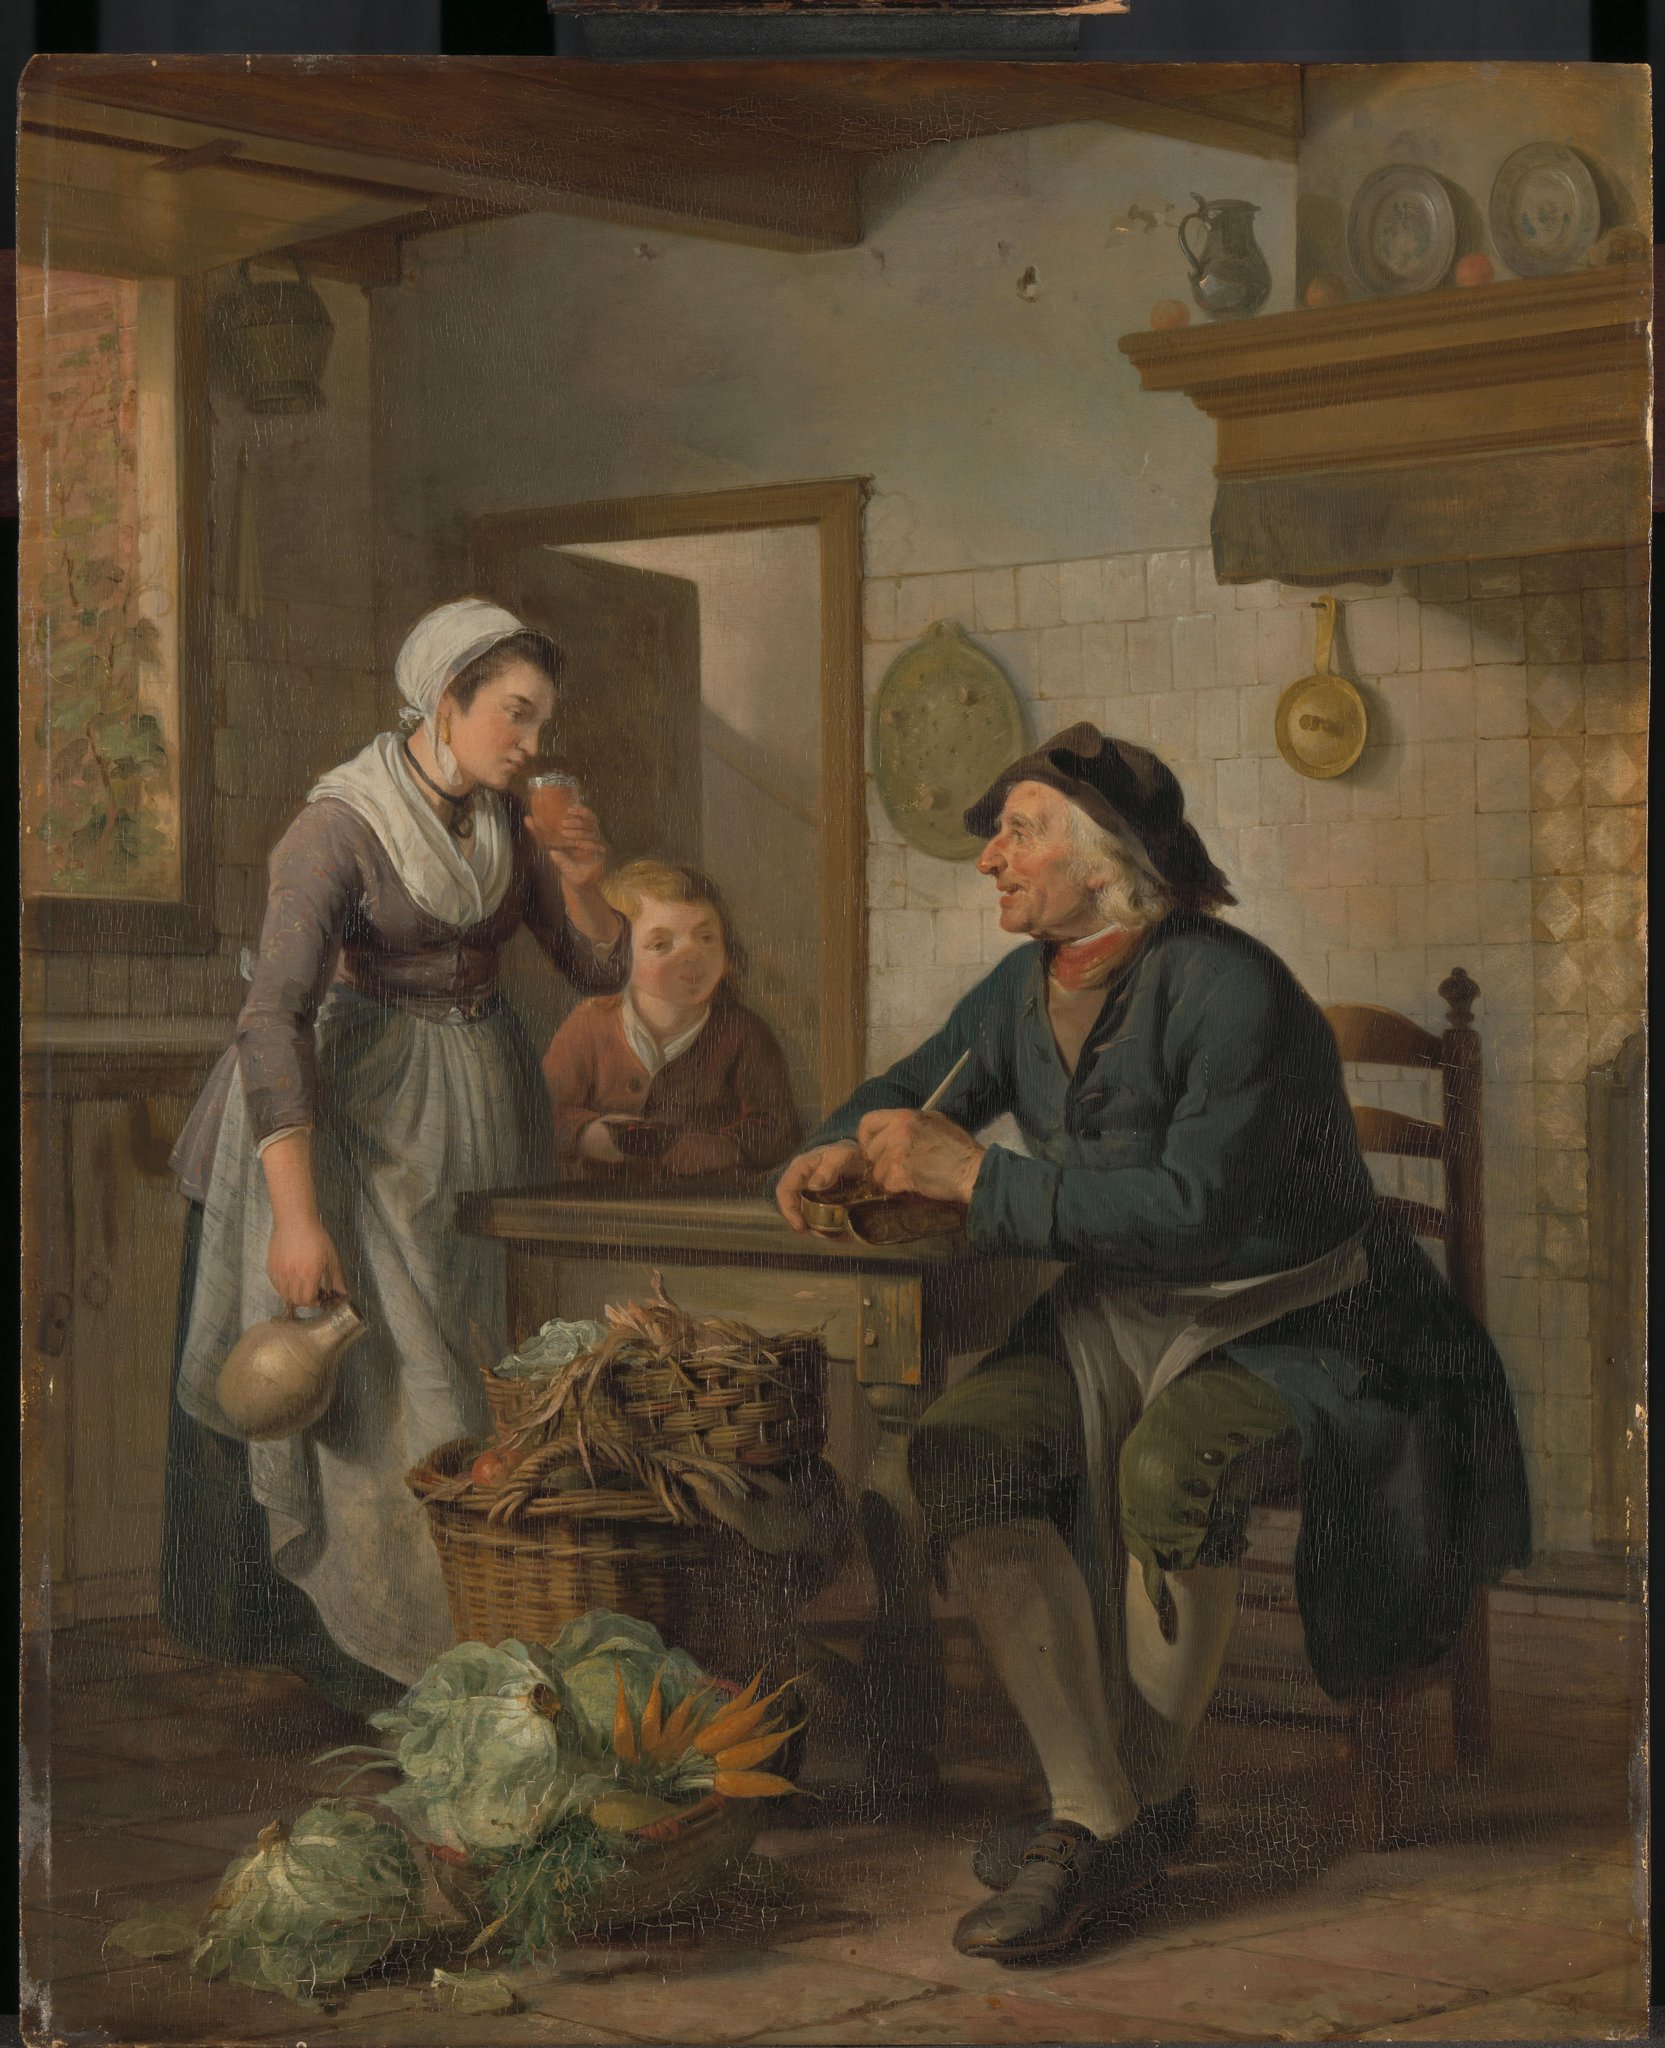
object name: painting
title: Morning Visit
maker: adriaan de lelie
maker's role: draughtsman, painter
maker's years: 1755-1820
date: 1796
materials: oil, panel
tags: vegetables, kitchen, old man, drinking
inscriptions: signature and date: ‘A. de Lelie Ft 1796’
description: The greengrocer has delivered his produce and before moving on has a chat with the maidservant. De Lelie painted this old Dutch kitchen scene in the tradition of 17th-century genre painting. He was interested in rendering the various details as faithfully as possible: the baskets of vegetables, the earthenware jug, the pewterware on the fireplace mantel and the brassutensils against the white tiles.